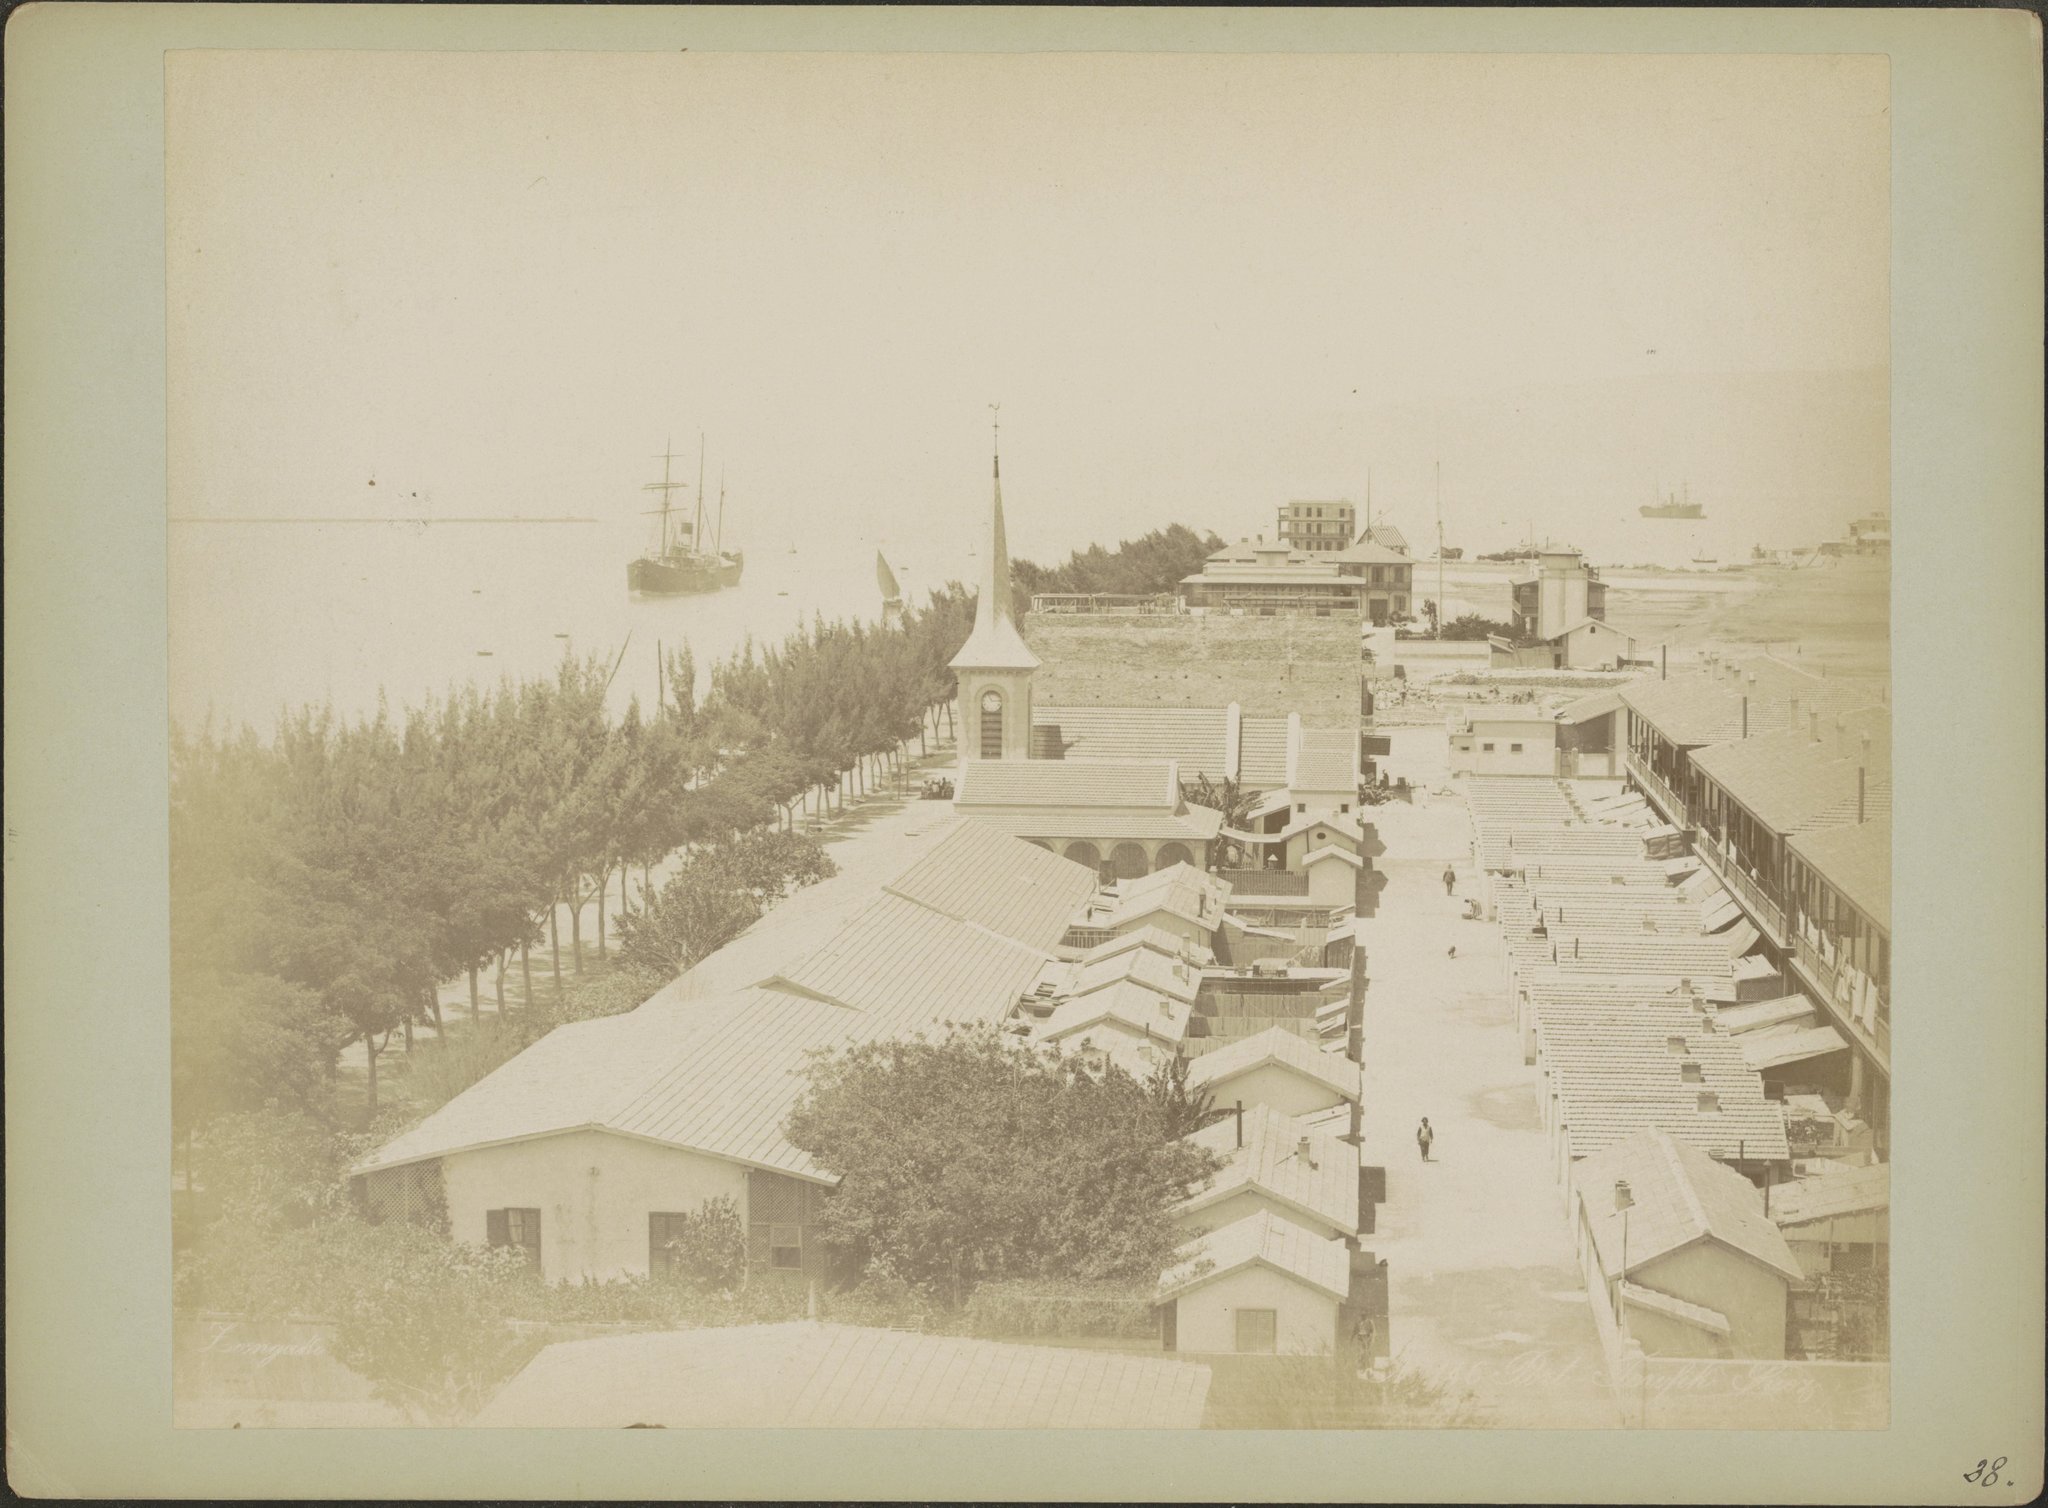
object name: album leaf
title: Gebouwen en katholieke kerk in Port Tawfik (Port Taufiq) aan de ingang van het Suezkanaal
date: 1870-1890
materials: cardboard, paper, photographic support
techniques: albumen print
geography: suez canal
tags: harbour (+ view ~ vehicle, ship, etc.), canal, church (exterior)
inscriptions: inscription: ‘Suez. Ingang v/h Kanaal.’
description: Onderdeel van Reisalbum met foto's van bezienswaardigheden in Marseille, Port Said, Aden, Bombay, Colombo, Singapore en Nederlands-Indië.